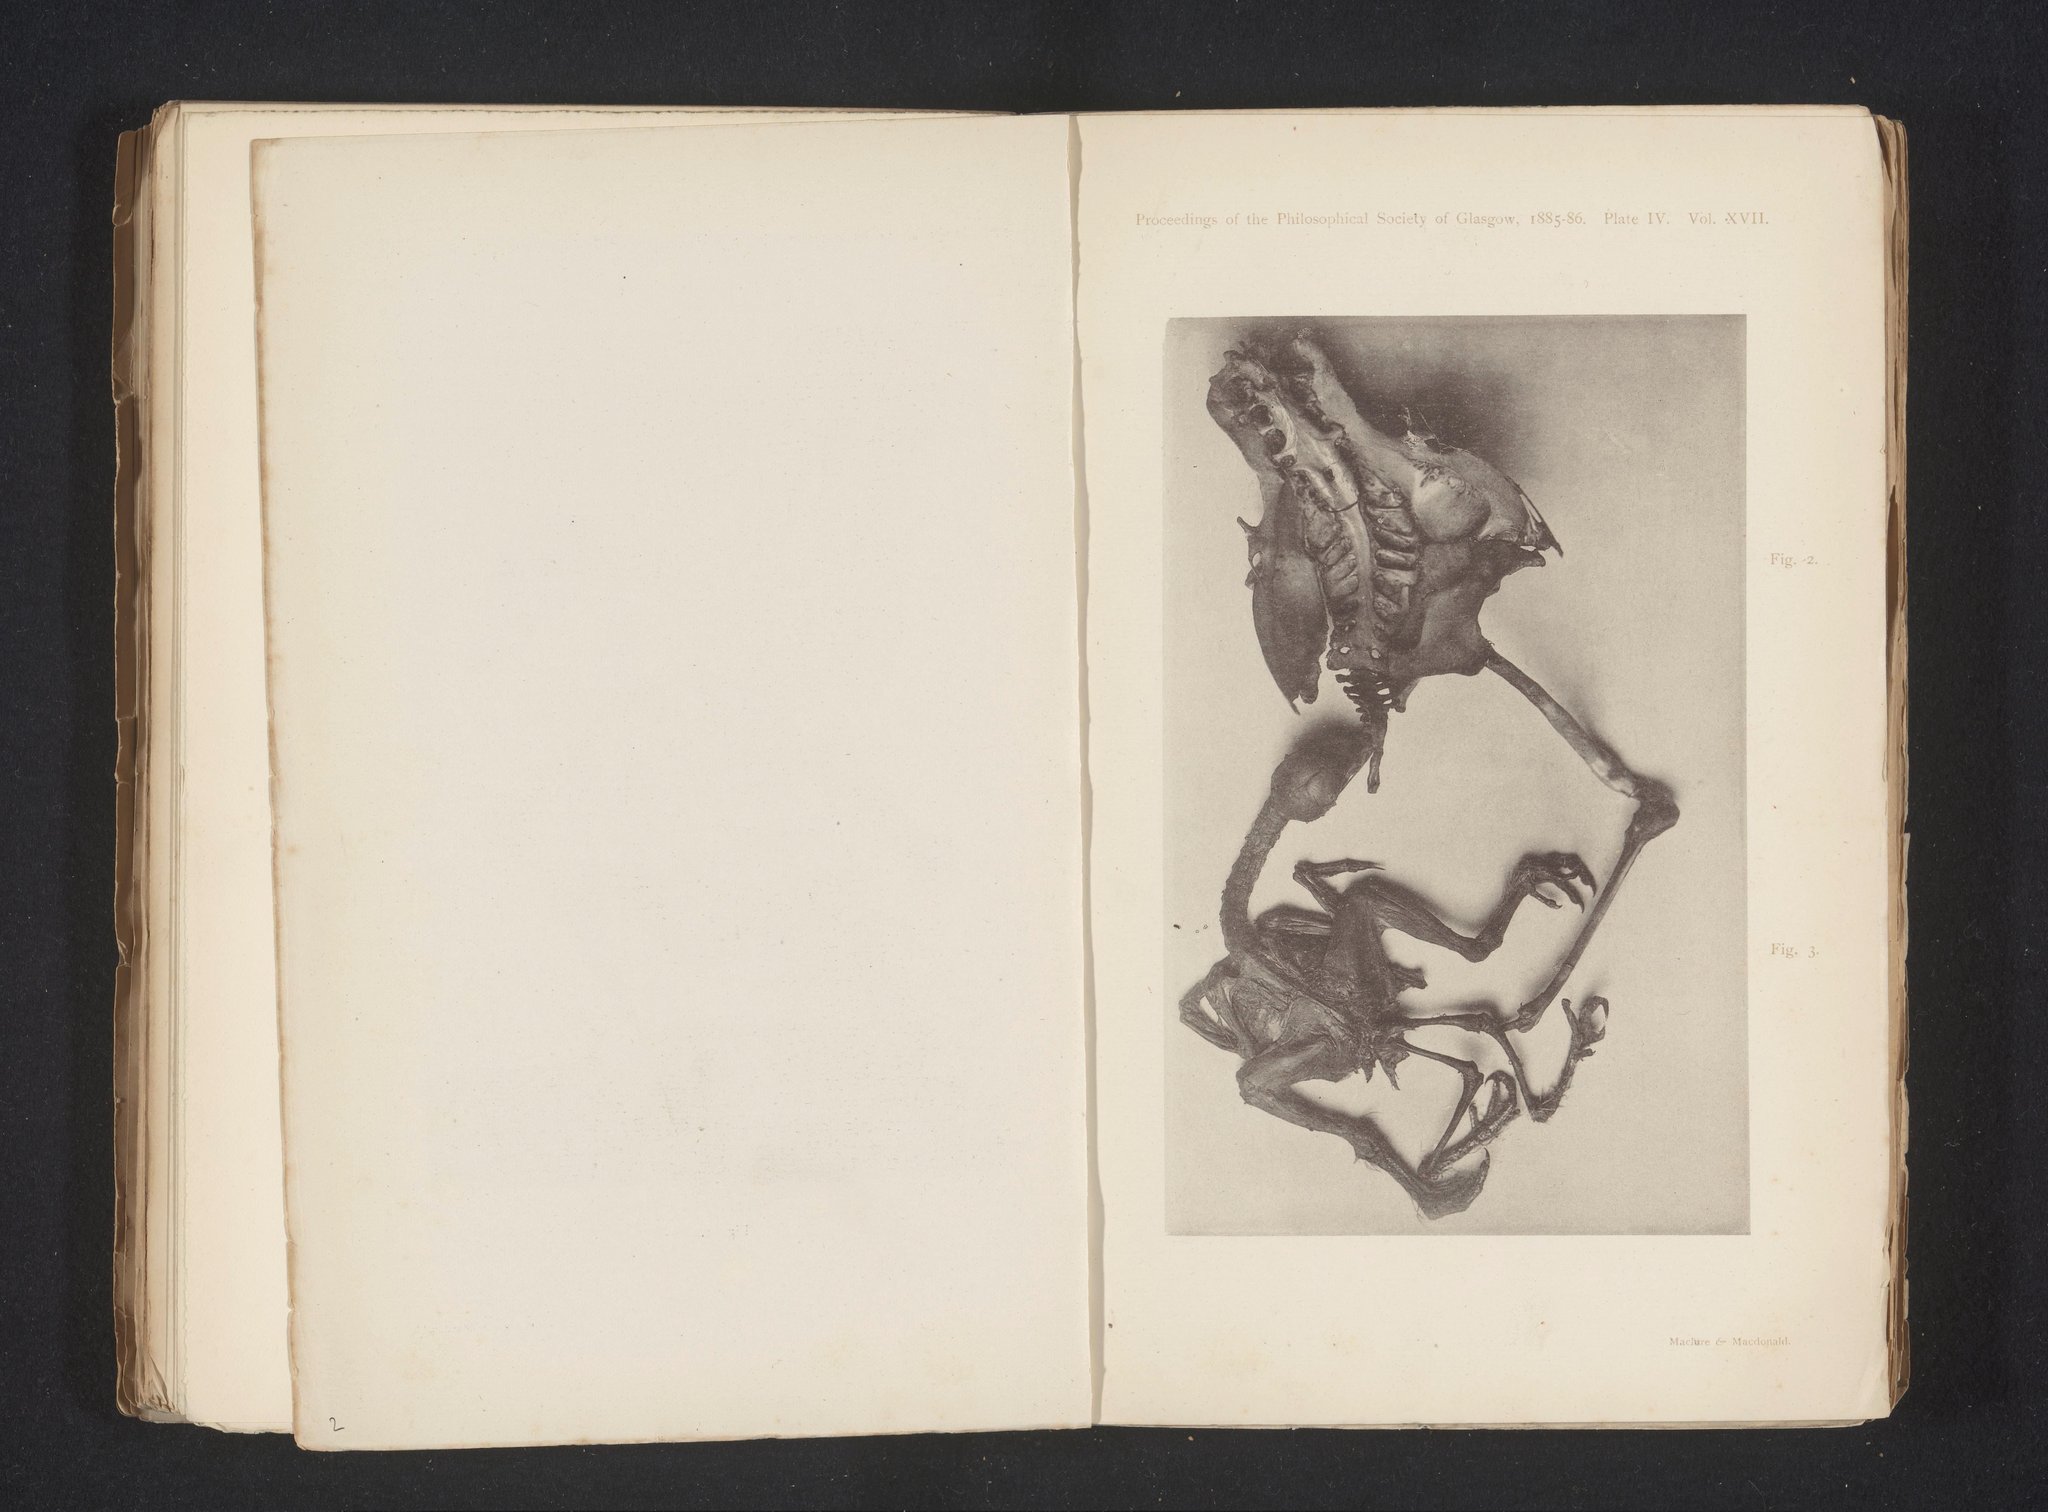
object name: page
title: Skelet van een fazant en een kuiken met extra ledematen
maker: Anonymous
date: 1881-1886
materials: photographic support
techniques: photograph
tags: birds (+ skeleton of an animal)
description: Prent op derde ongenummerde pagina na pagina 202.